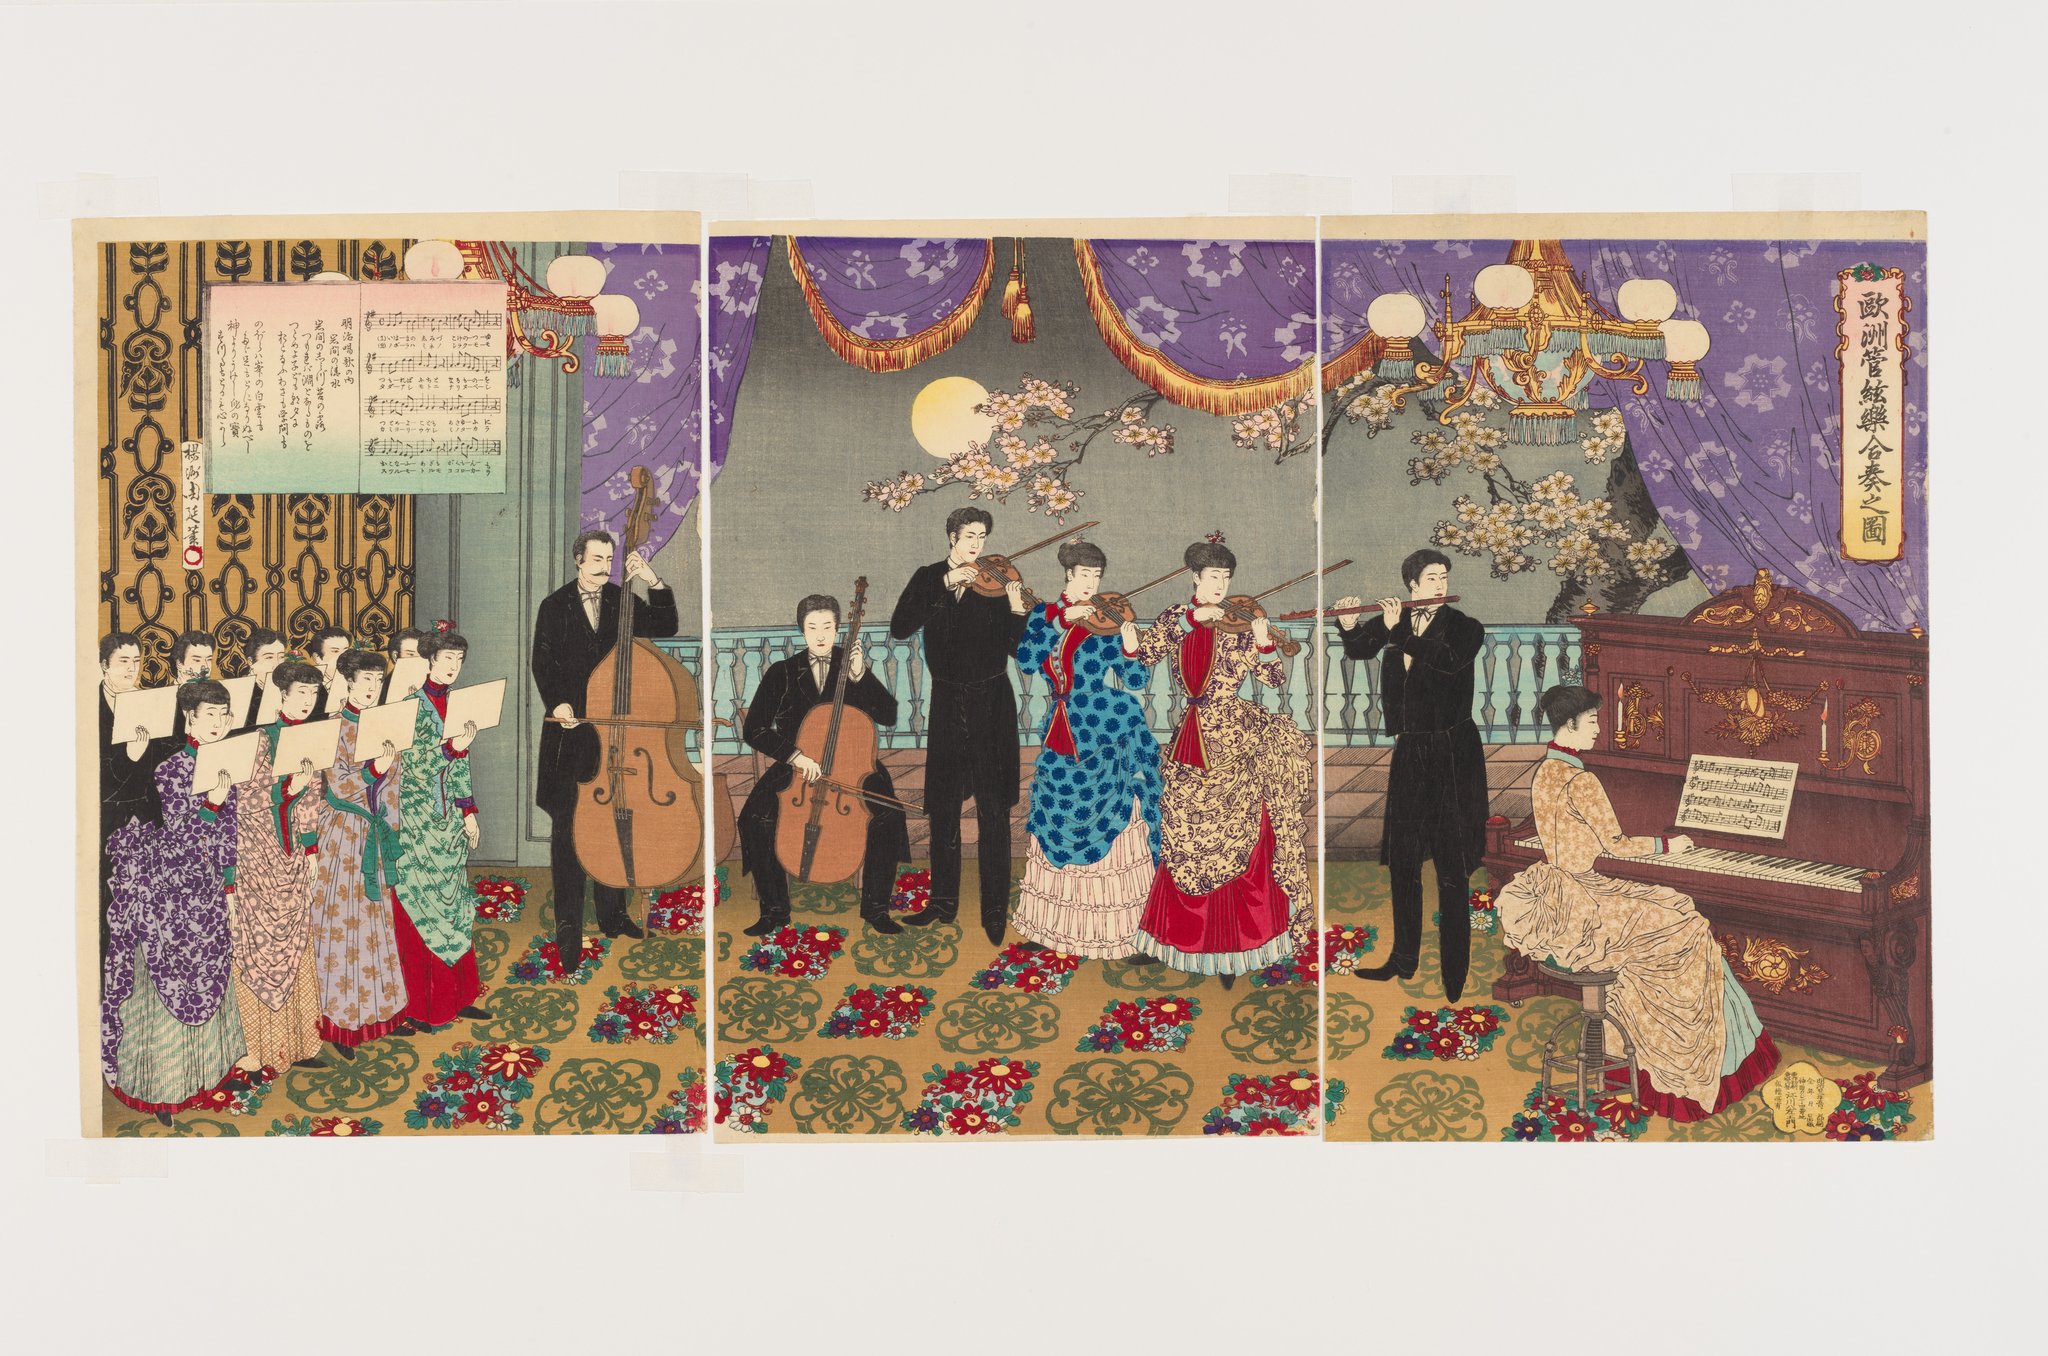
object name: print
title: Concert of European Music (Ōshū kangengaku gassō no zu)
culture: japanese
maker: yōshū (hashimoto) chikanobu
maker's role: artist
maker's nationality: japanese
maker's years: 1838-1912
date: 1889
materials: ink, paper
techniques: woodblock print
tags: musical instruments,men,women,concerts,singing,cellos,pianos,violins